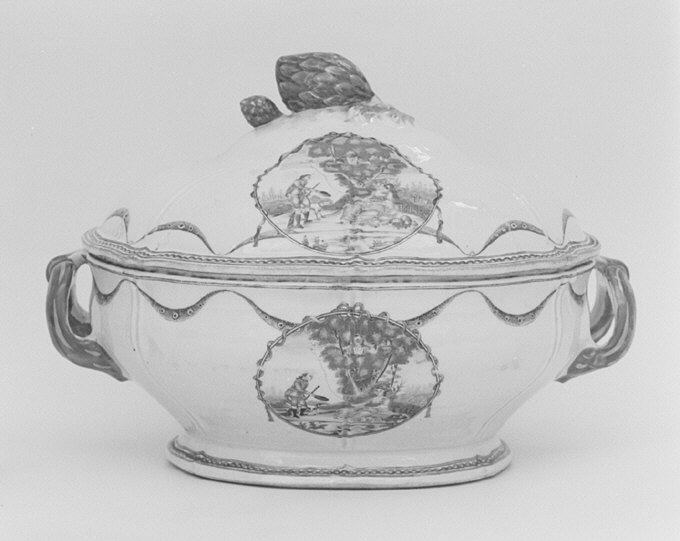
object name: tureen with cover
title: Tureen with cover (part of a service)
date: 1750-1770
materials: hard paste porcelain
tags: men,women